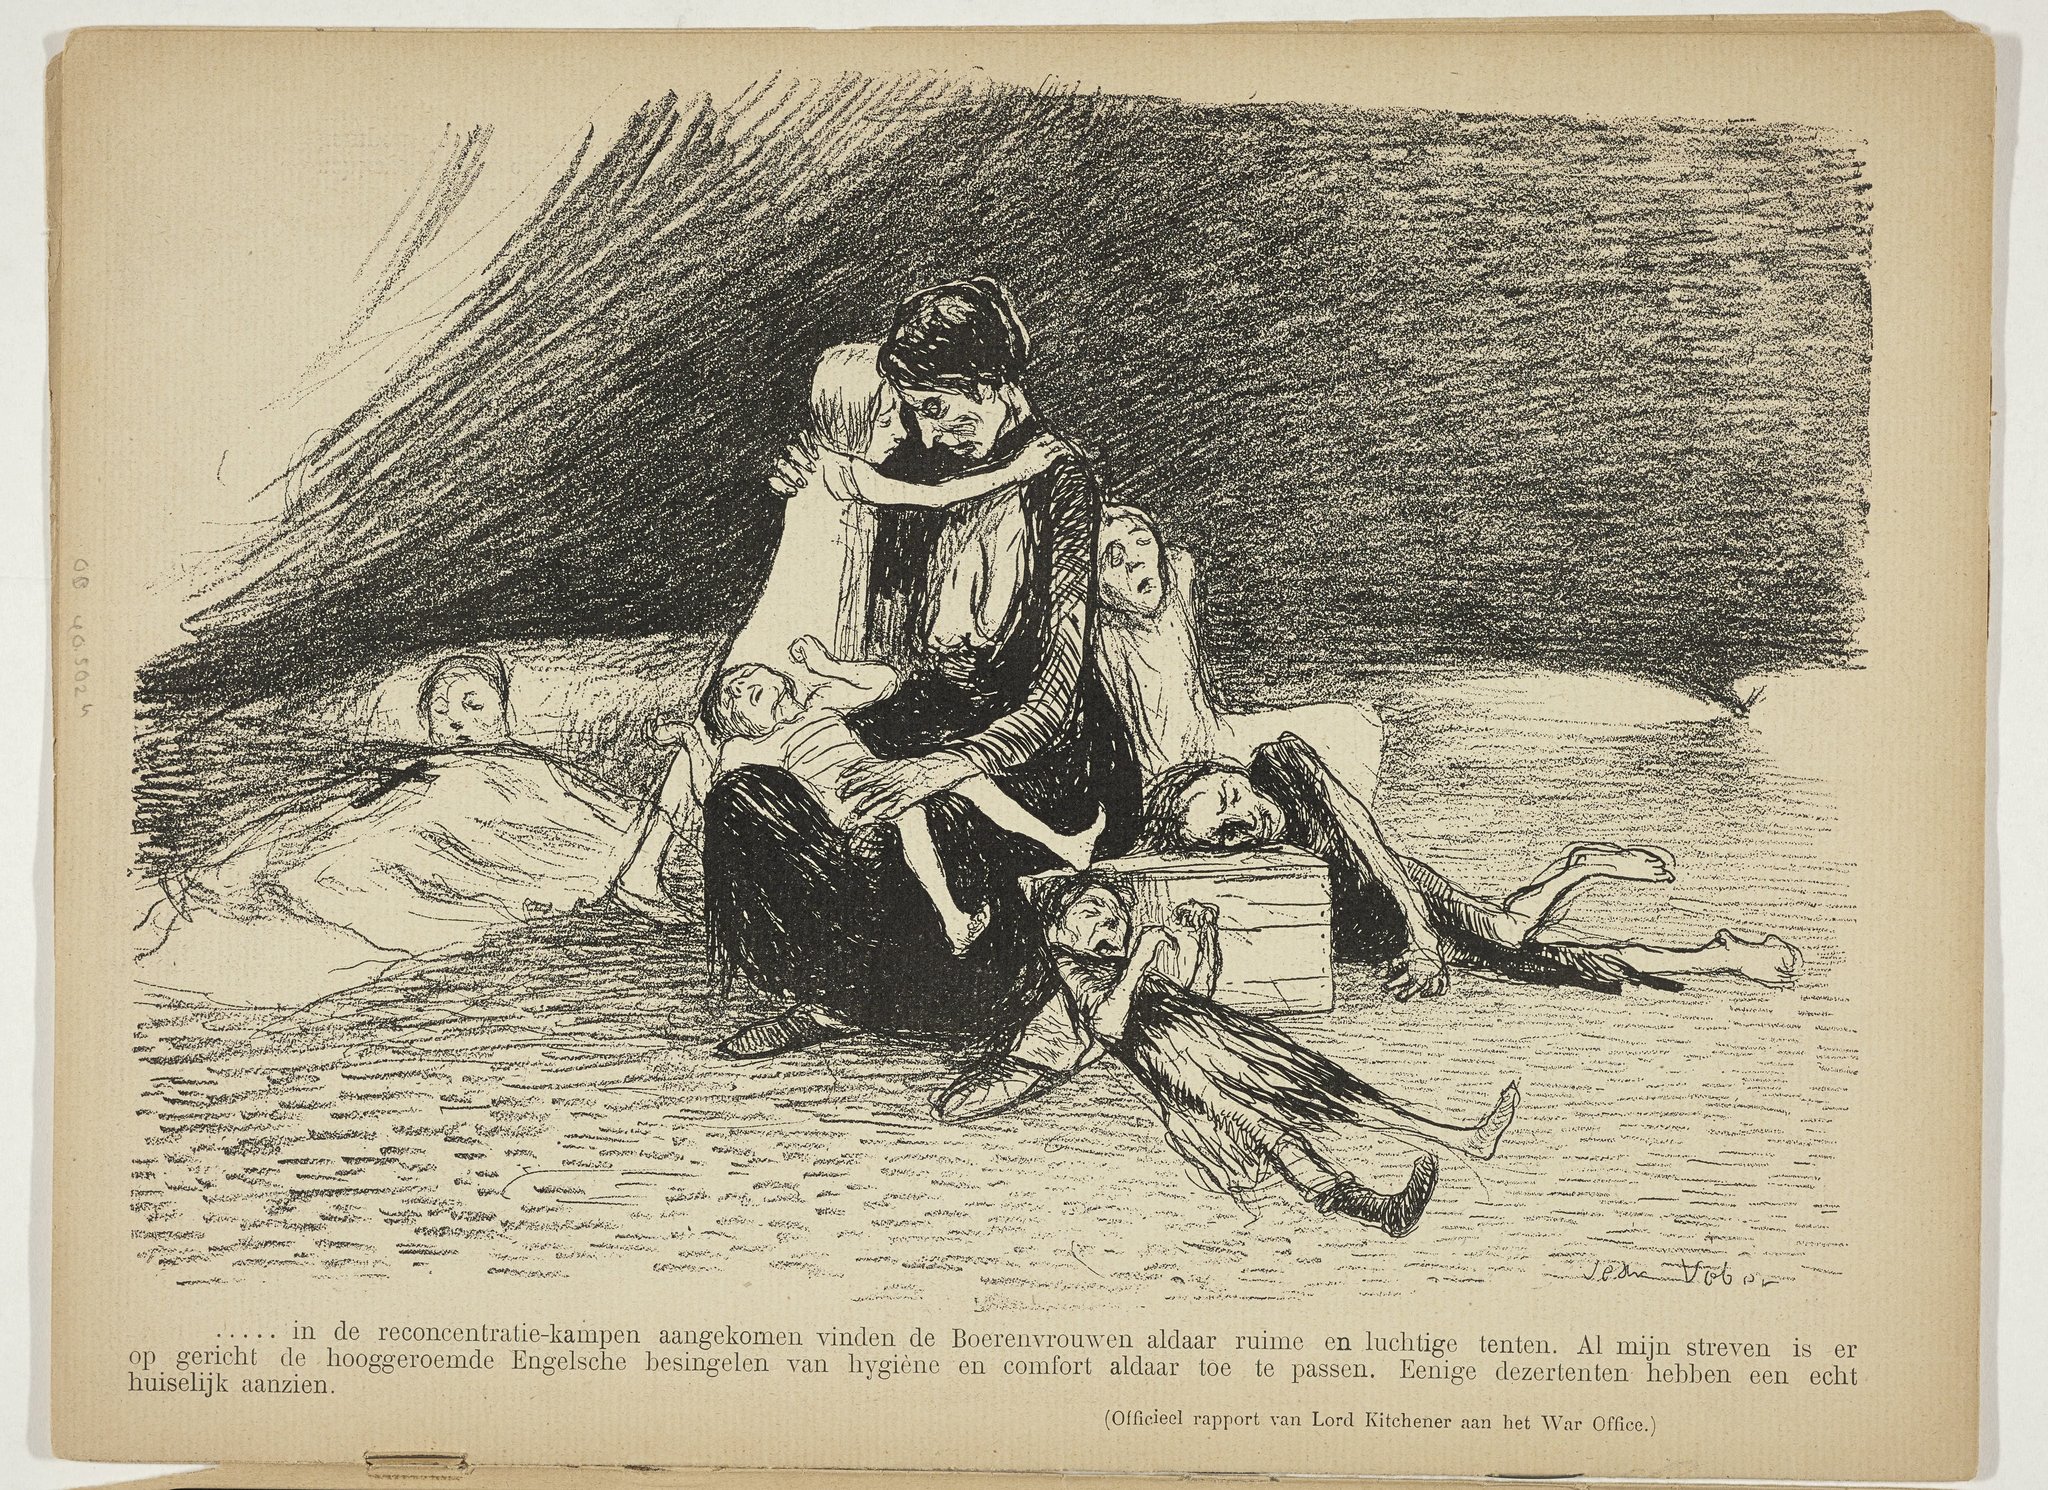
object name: cartoon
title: Vermagerde Boerenvrouw en -kinderen in een concentratiekamp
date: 1901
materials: paper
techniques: letterpress printing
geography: paris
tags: concentration camp, horrors of war, starvation, famine, political caricatures and satires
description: Prent maakt deel uit van een tijdschrift met spotprenten op de Tweede Boerenoorlog. Met vierregelig onderschrift: ..... in de reconcentratie-kampen aangekomen vinden de Boerenvrouwen aldaar ruime en luchtige tenten ... (Officieel rapport van Lord Kitchener aan het War Office.).